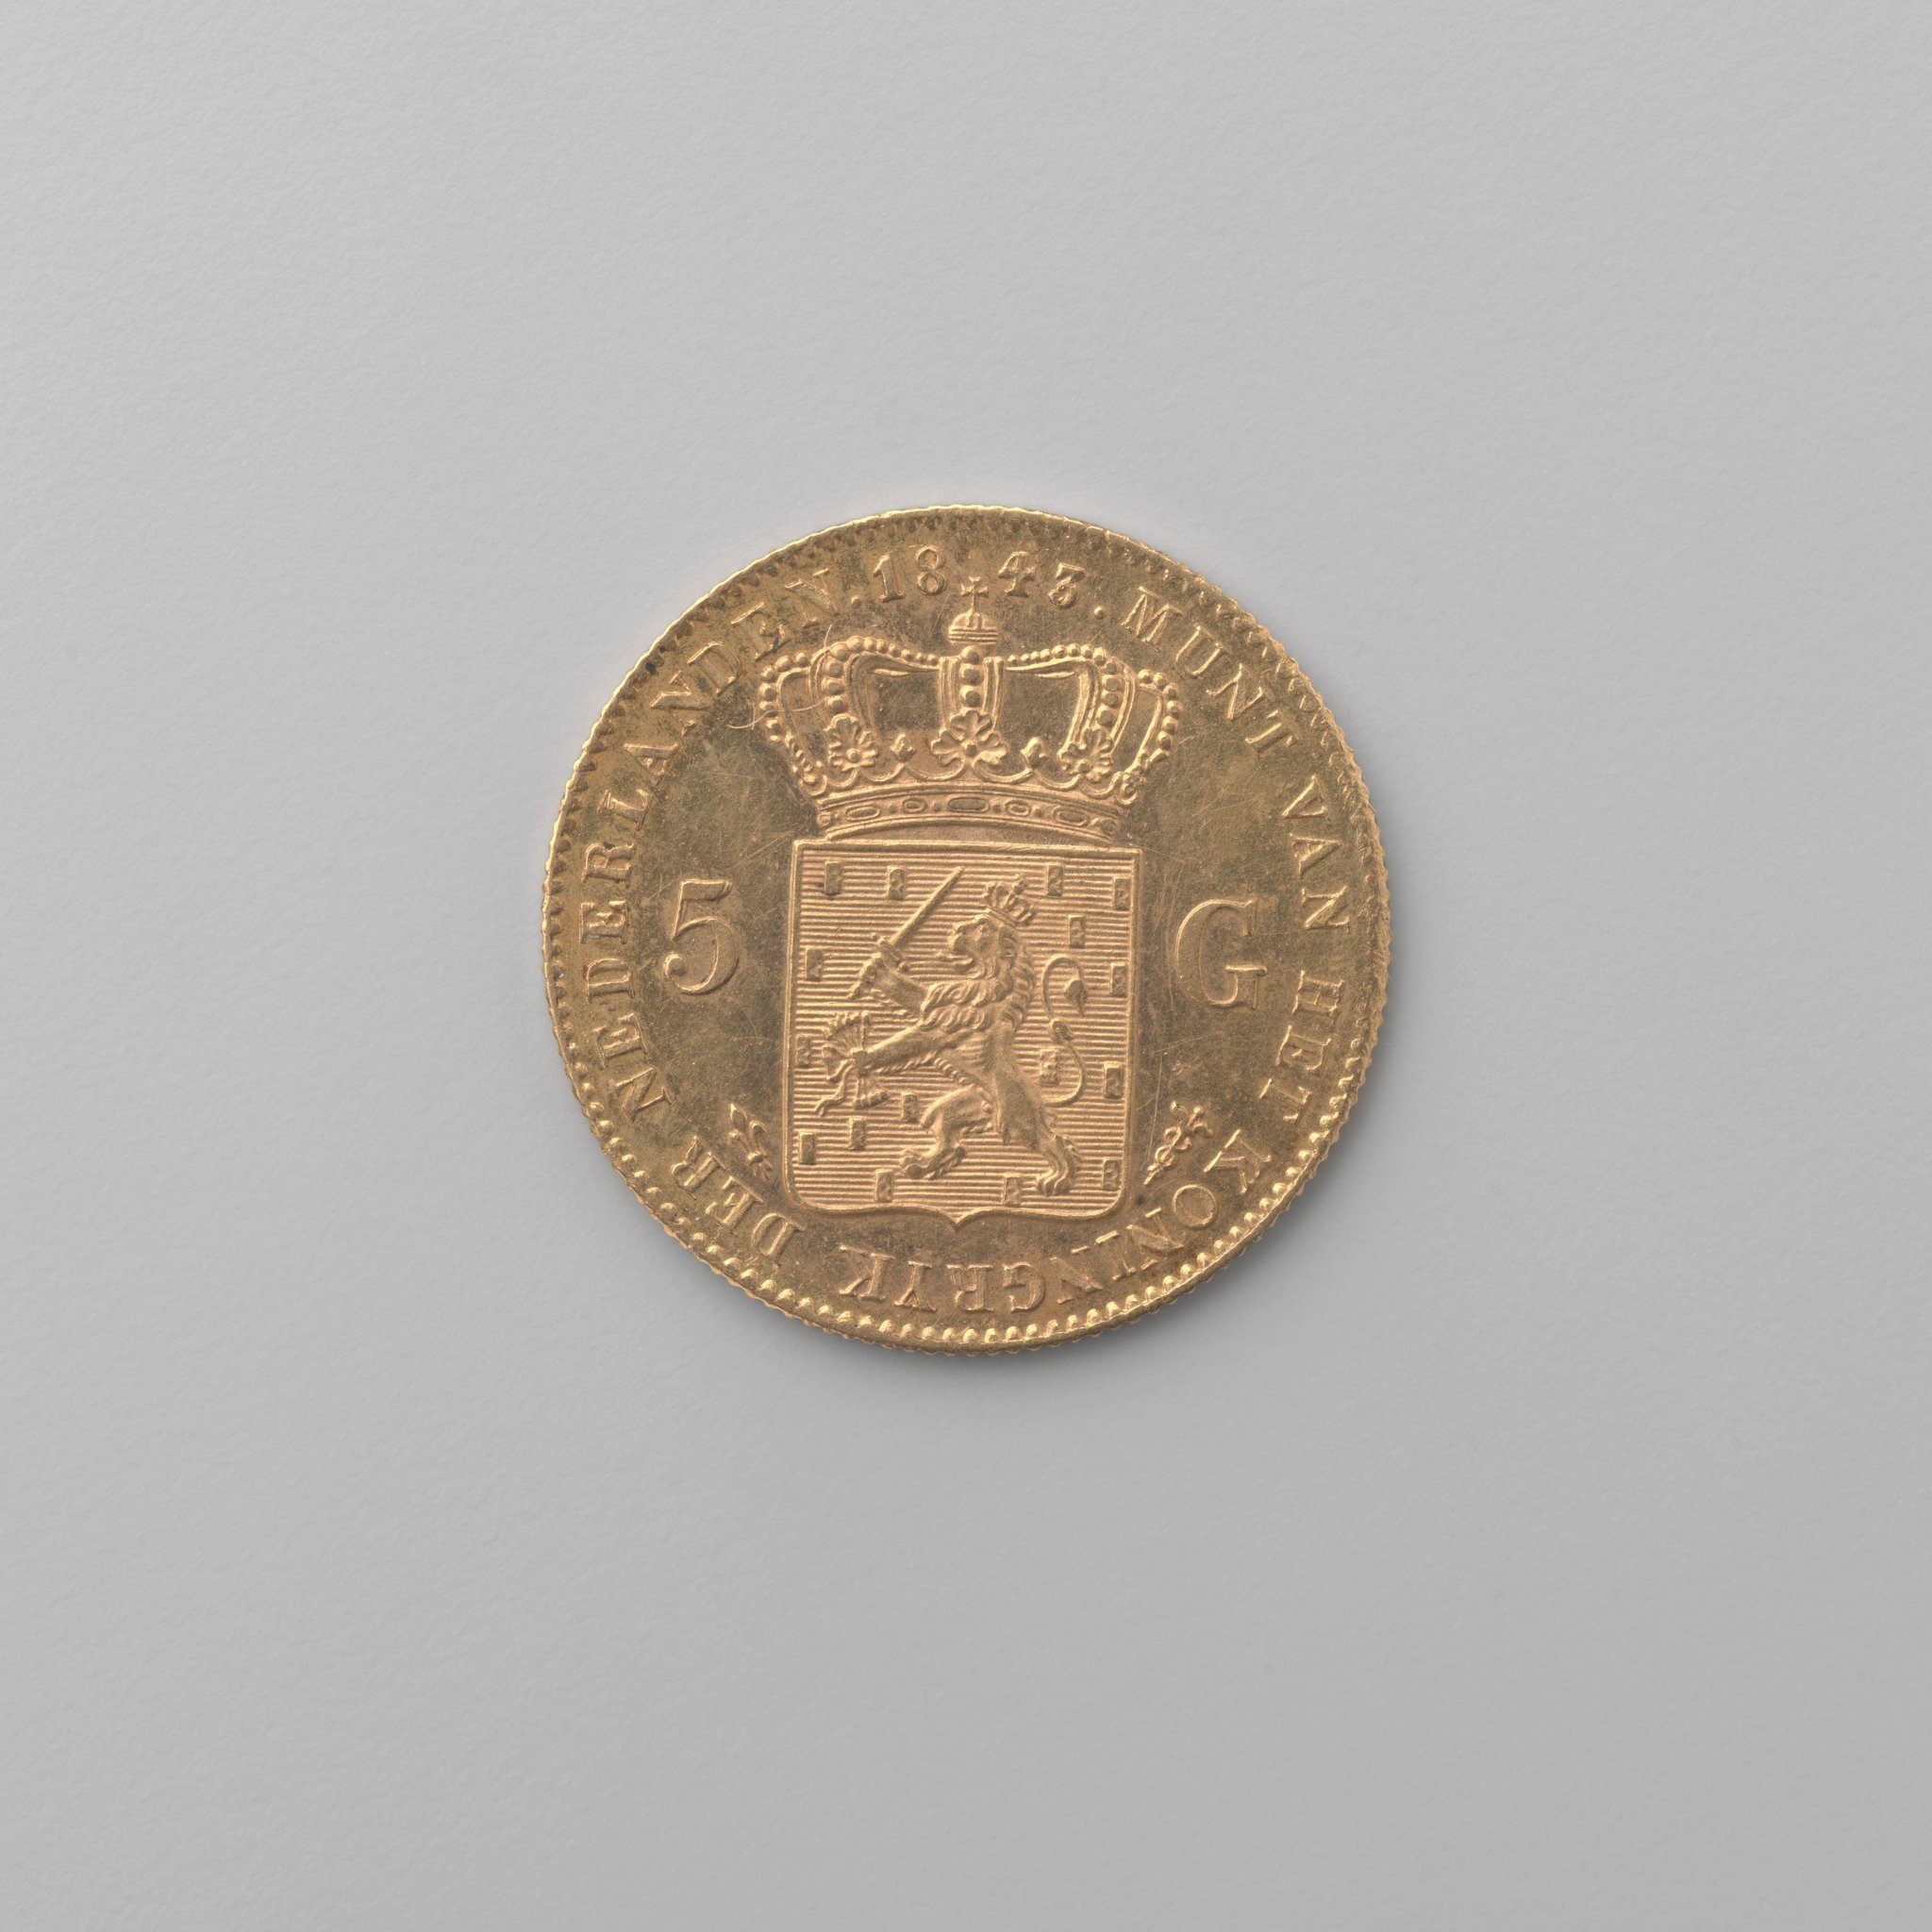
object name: coin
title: Nederland, 5 gulden, 1843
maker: william ii of the netherlands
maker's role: koning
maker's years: 1792-1849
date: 1843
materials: gold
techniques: striking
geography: utrecht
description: Gouden munt. Voorzijde: borstbeeld naar rechts. Keerzijde: tussen waarde-aanduiding 5 G gekroond rijkswapenschild. Jaartal boven kroon. Kartelrand.